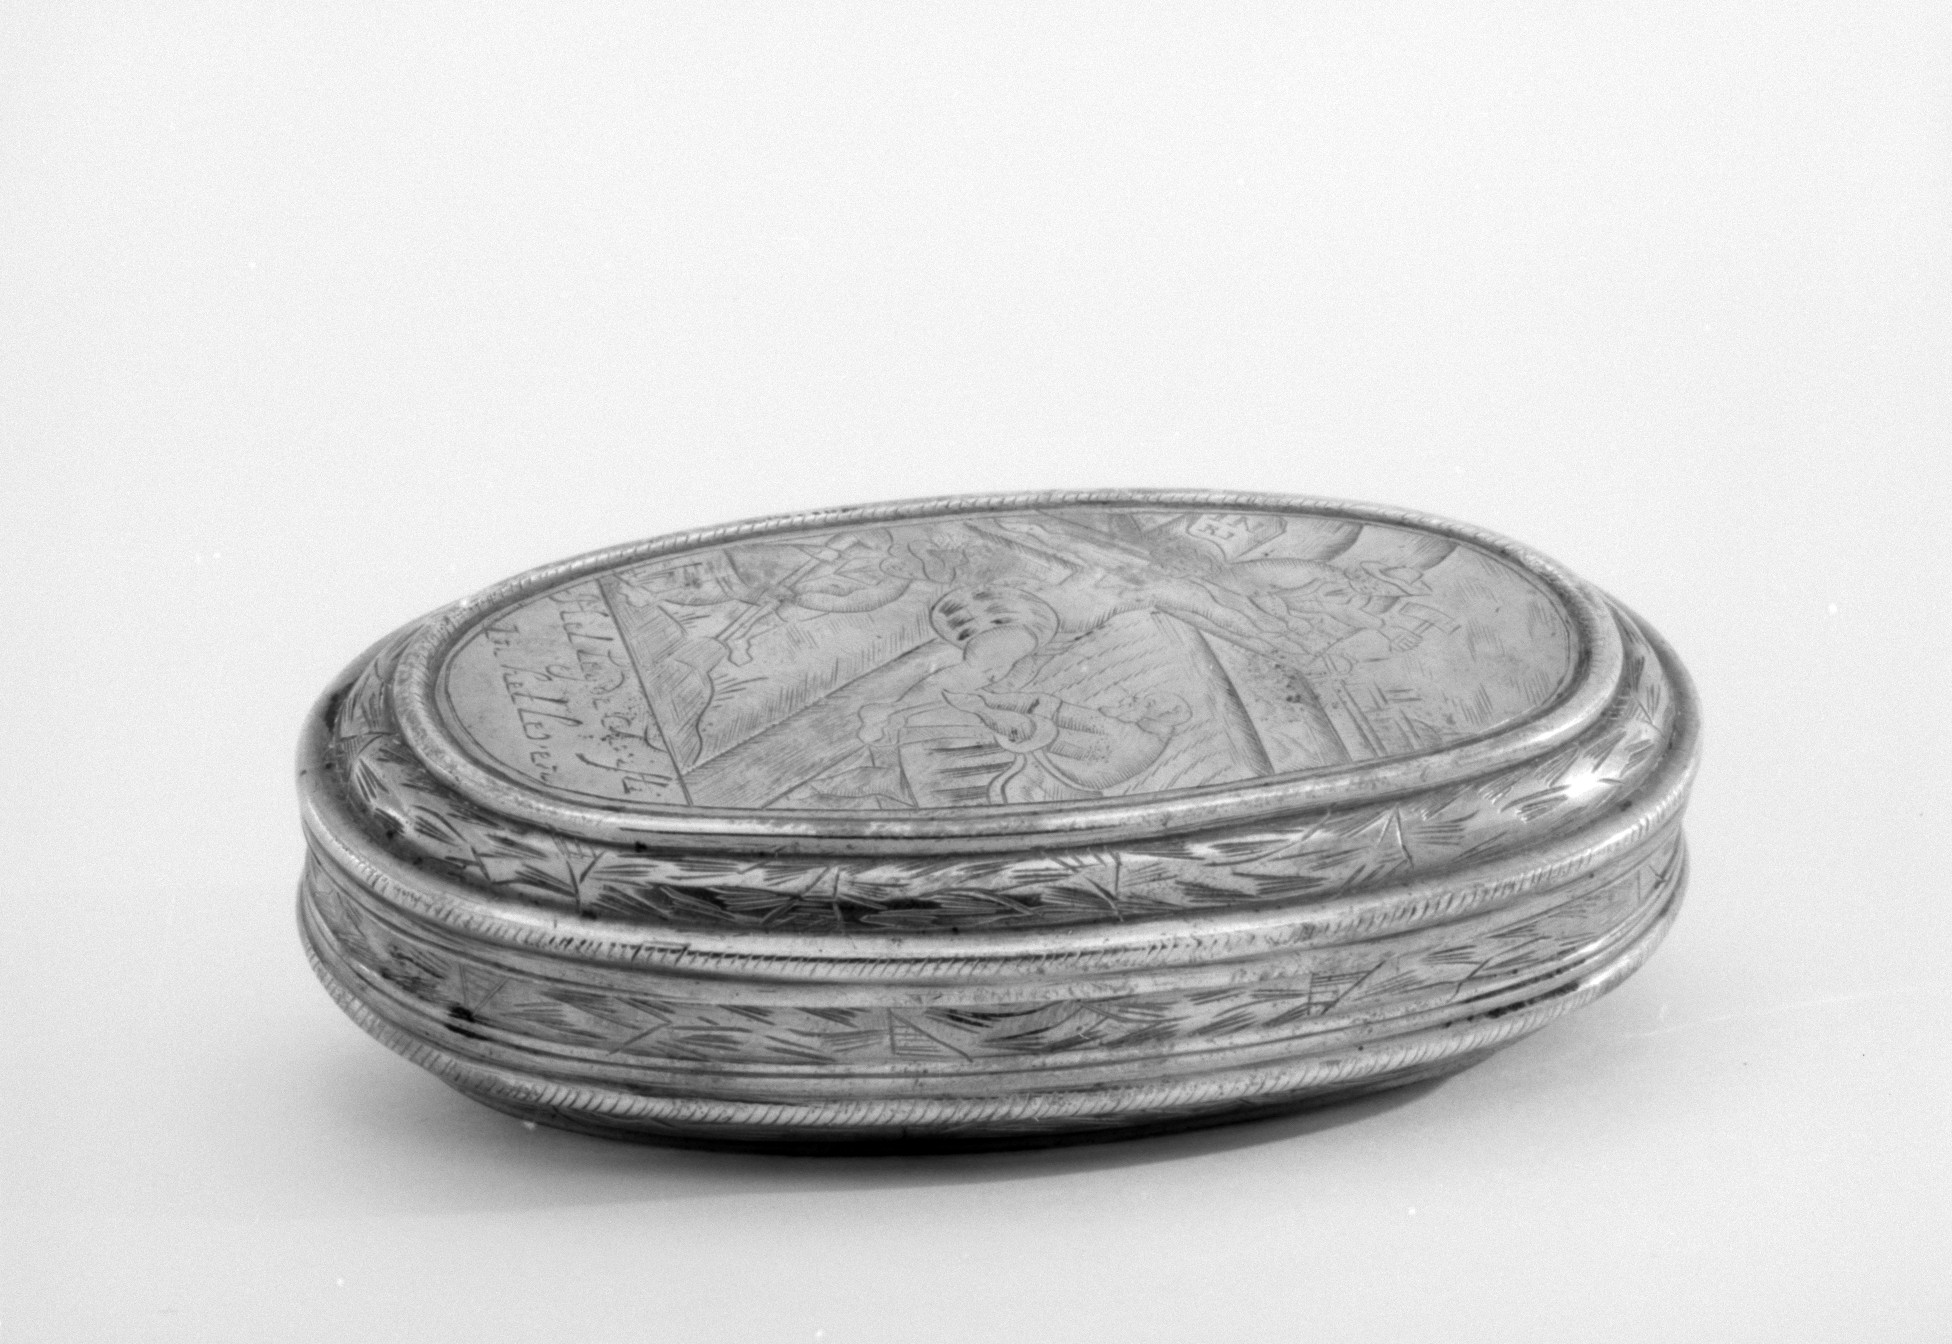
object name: tobacco box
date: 1601-1800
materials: brass, copper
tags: men,jesus,crucifixion